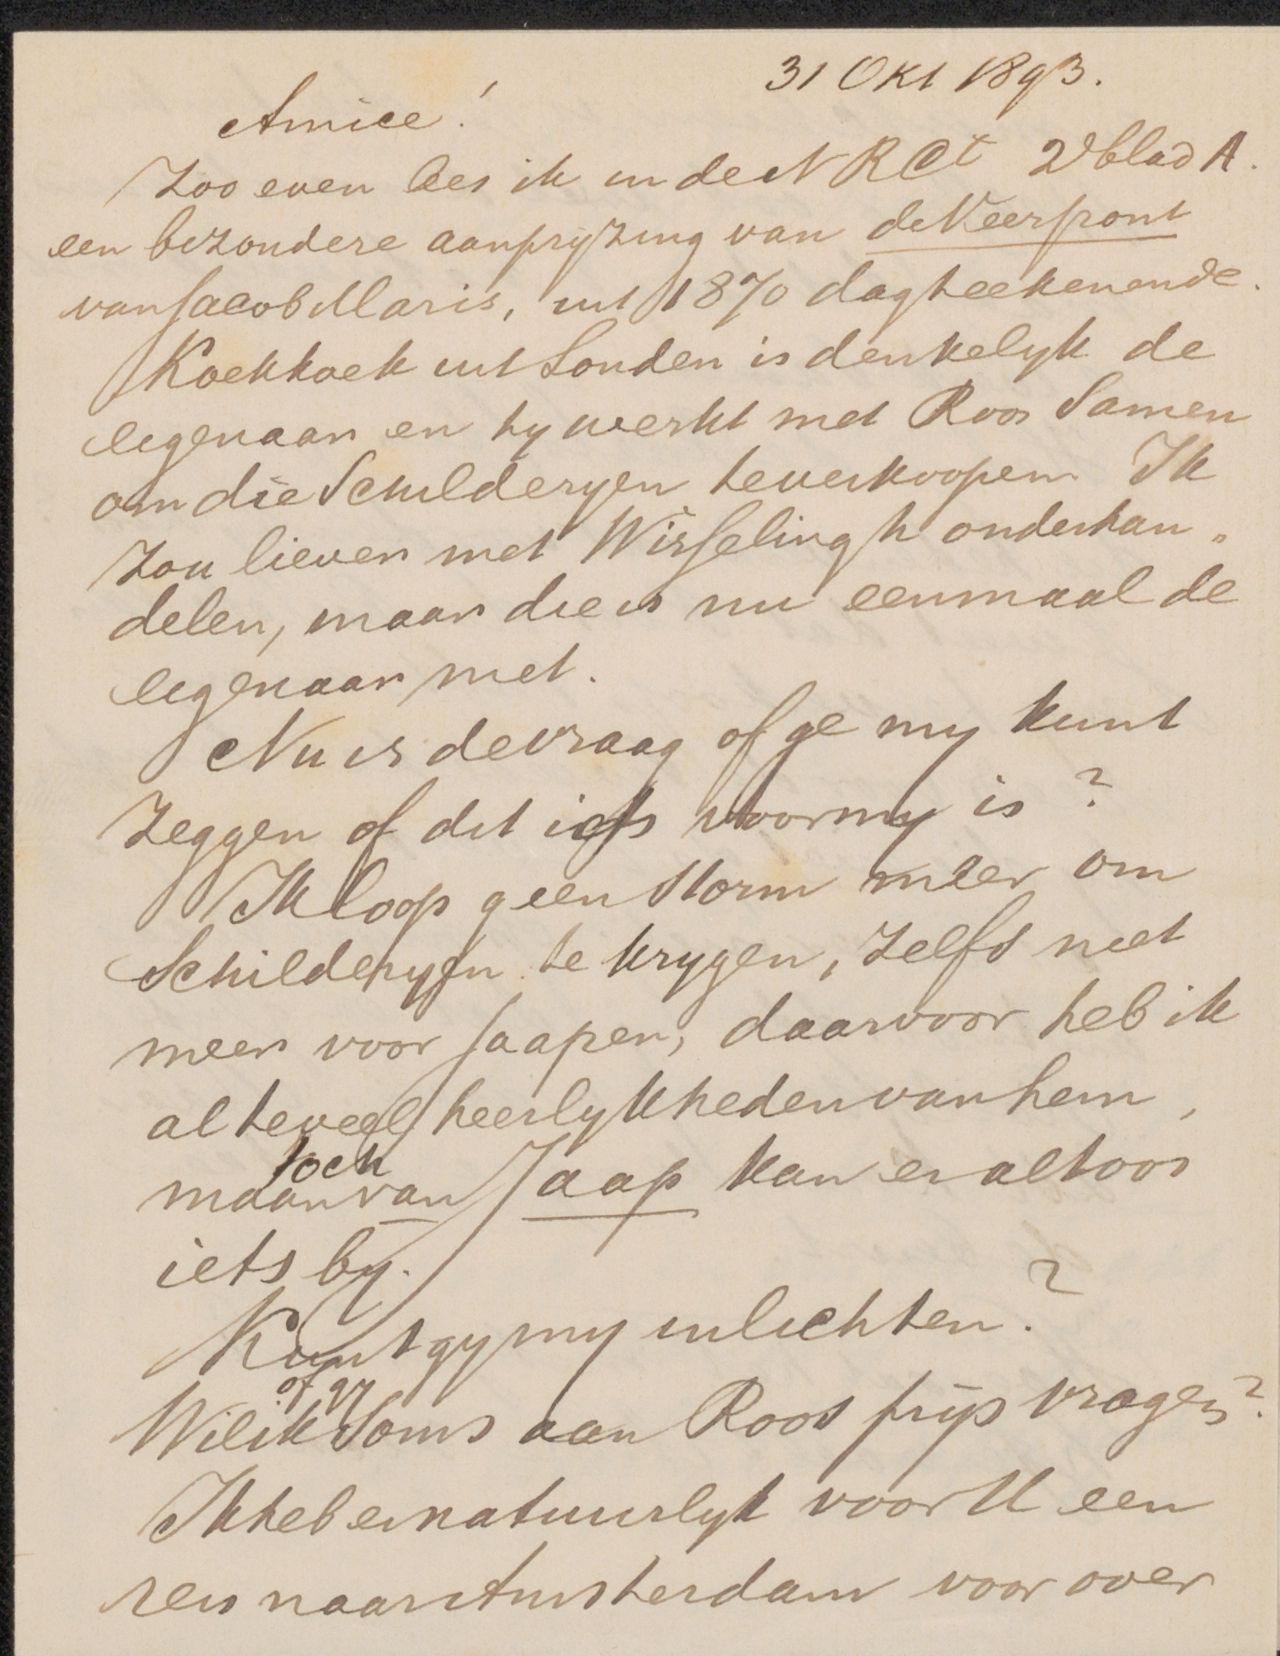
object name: letter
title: Brief aan Jan Veth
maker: martinus cornelis lebret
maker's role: verzamelaar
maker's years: 1833-1894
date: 1893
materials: ink, paper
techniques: pen, writing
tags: amsterdam, willem roelofs (i), dordrecht, designer, jan veth, the hague, jacob maris, middelburg, cleves, painter, print maker, draughtsman, barend cornelis koekkoek, elbert jan van wisselingh, hermanus gijsbertus tersteeg, art trade, art shop, painting (including book-illumination, miniature-painting), exhibition ~ art, diseases, art collecting, historical persons (portraits and scenes from the life), london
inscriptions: collector's mark: ‘RPK’